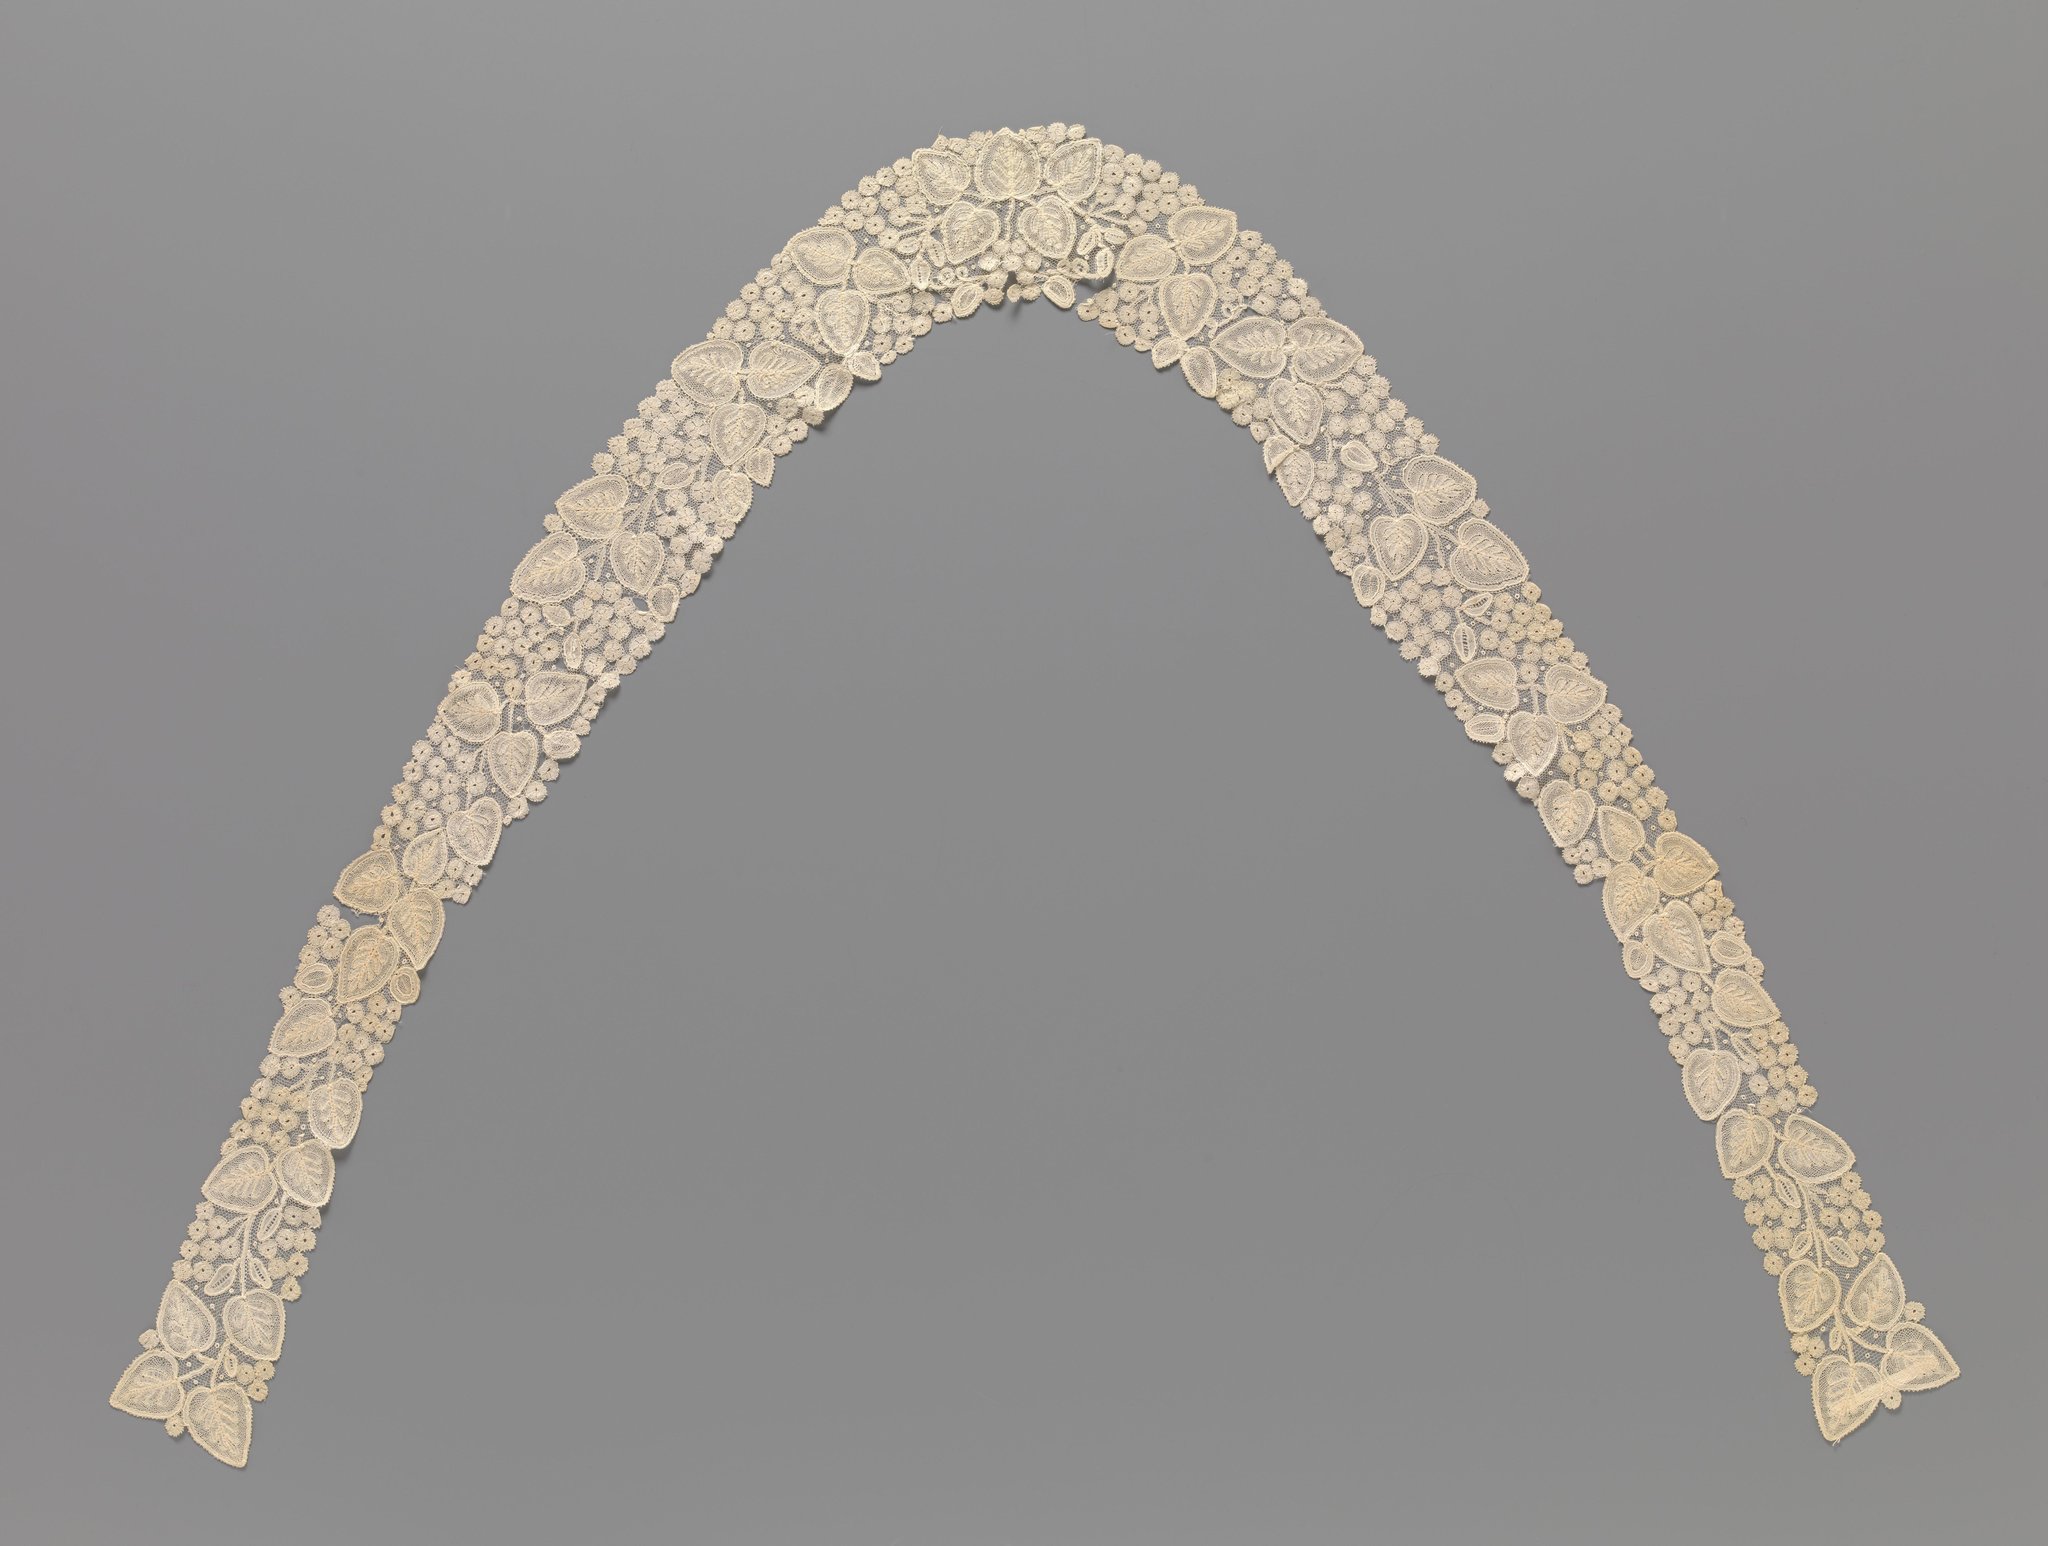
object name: collar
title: Kraag van gemengde kant met hartvormige bladeren tussen trossen rozetbloempjes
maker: Anonymous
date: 1875-1899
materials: linen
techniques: lace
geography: brussels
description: Kraag van naturelkleurige gemengde kant - kloskant in combinatie met een naaldkantgrond - Brusselse duchesse. V-vormig model met afgeronde wijde hoek en gevormd door een smalle strook die iets breder is in het middengedeelte. Het patroon bestaat uit hartvormige bladeren, in drie- en vijfvoud geplaatst. De velden tussen de bladeren zijn gevuld met trossen rozetbloempjes. De motieven zijn geklost in linnenslag en netslag. De grote motieven zijn geaccentueerd door contourdraden, die bestaan uit grof gehechte draadbundels. Rondom een schulpenrand.